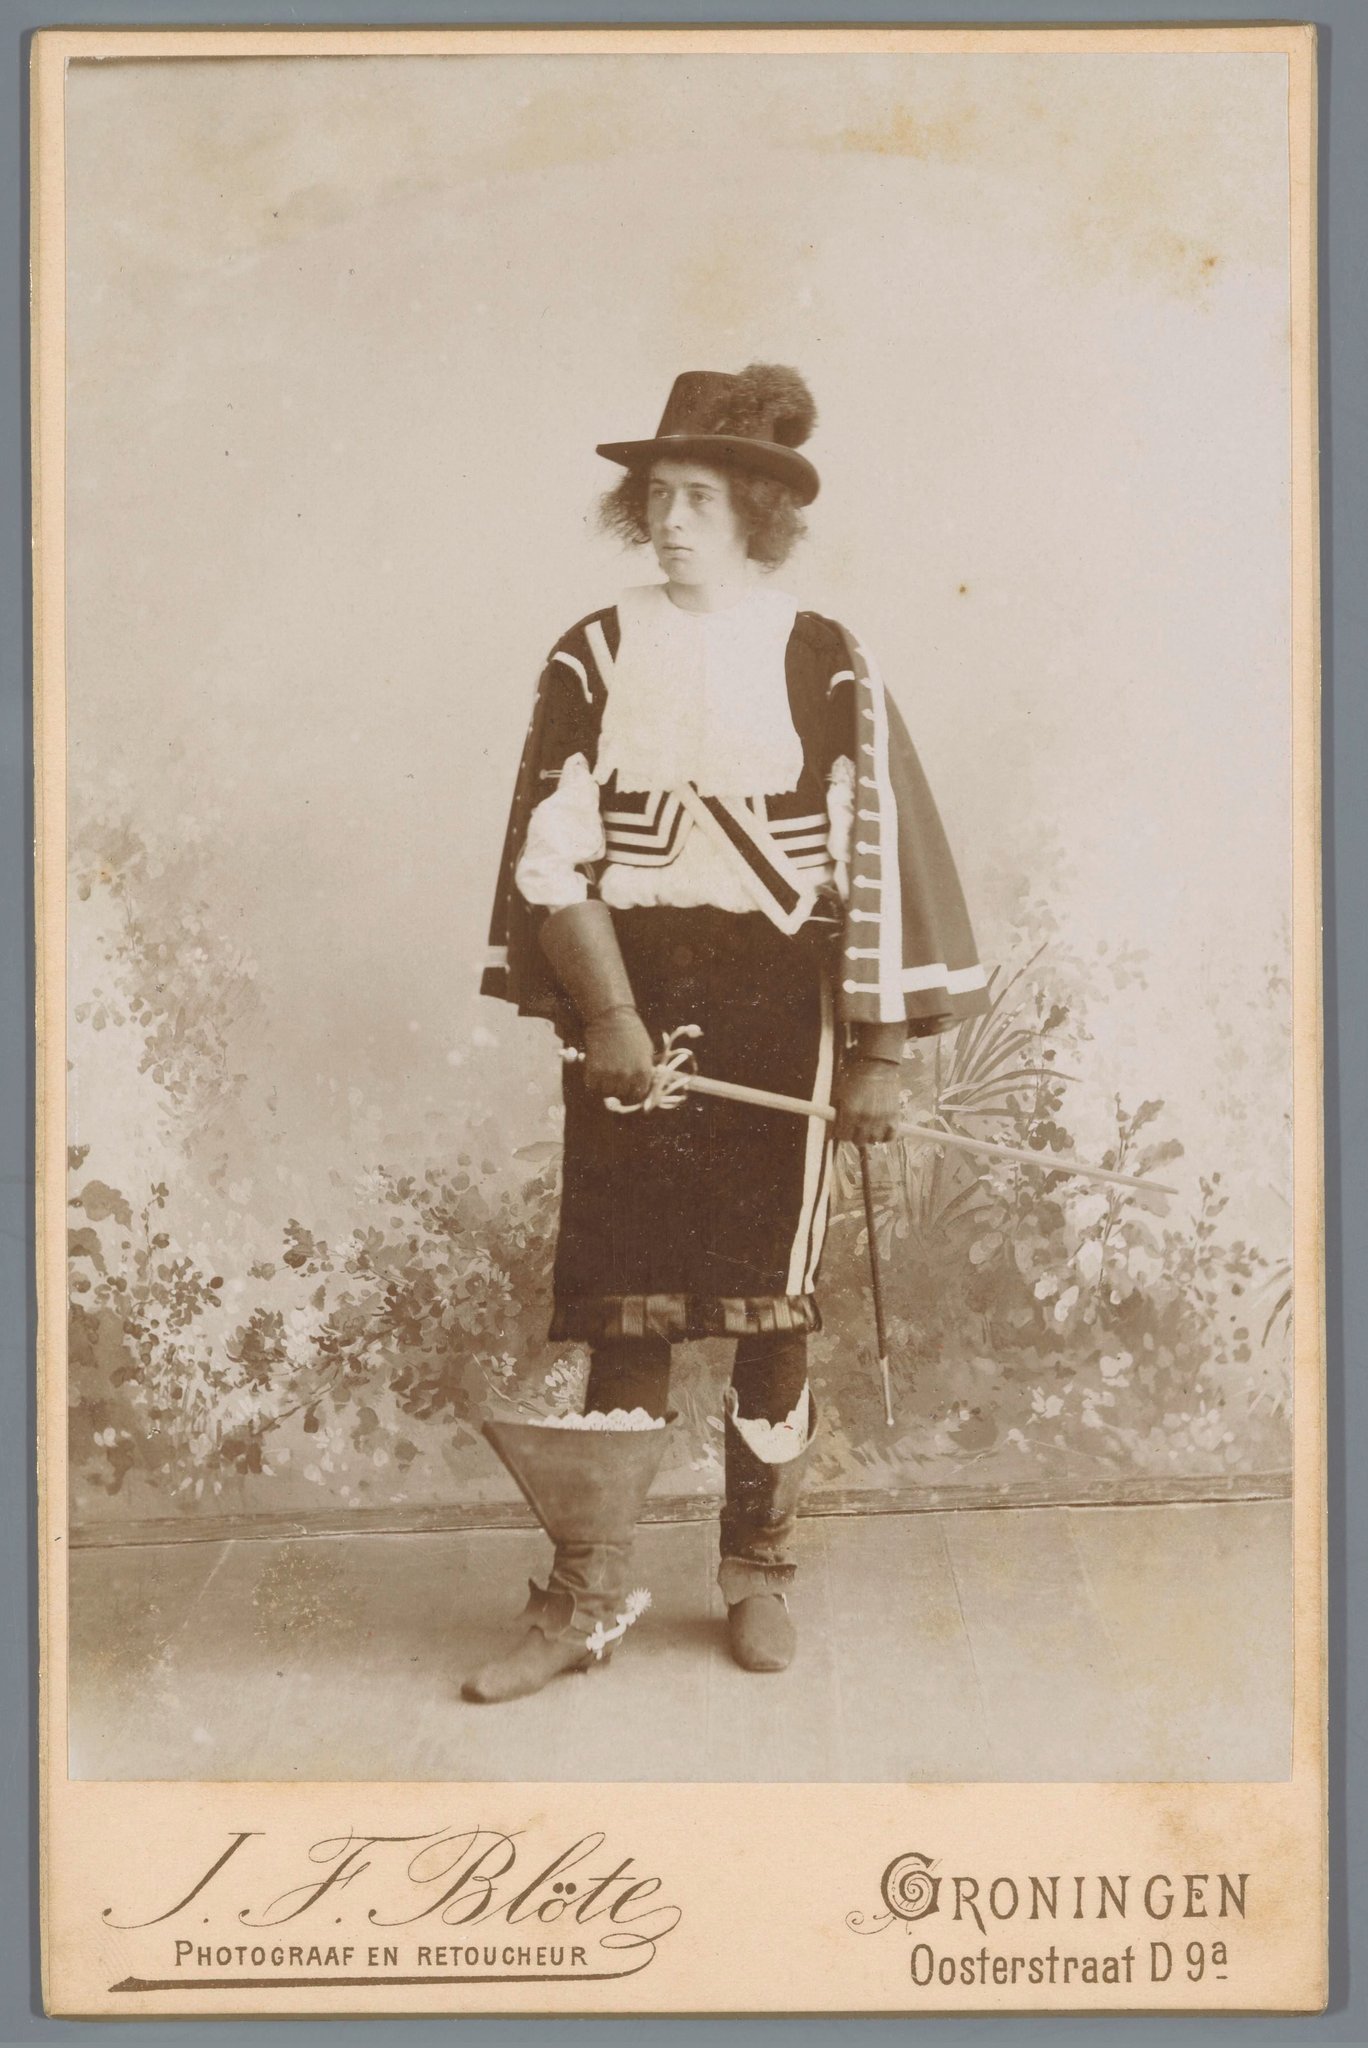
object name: photograph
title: Portret van een Groningse student in maskeradekostuum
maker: jan frederik blöte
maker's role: fotograaf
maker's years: 1865-1956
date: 1890-1900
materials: photographic support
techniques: collodion silver print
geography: groningen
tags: students' pageant, costumes used in pageants